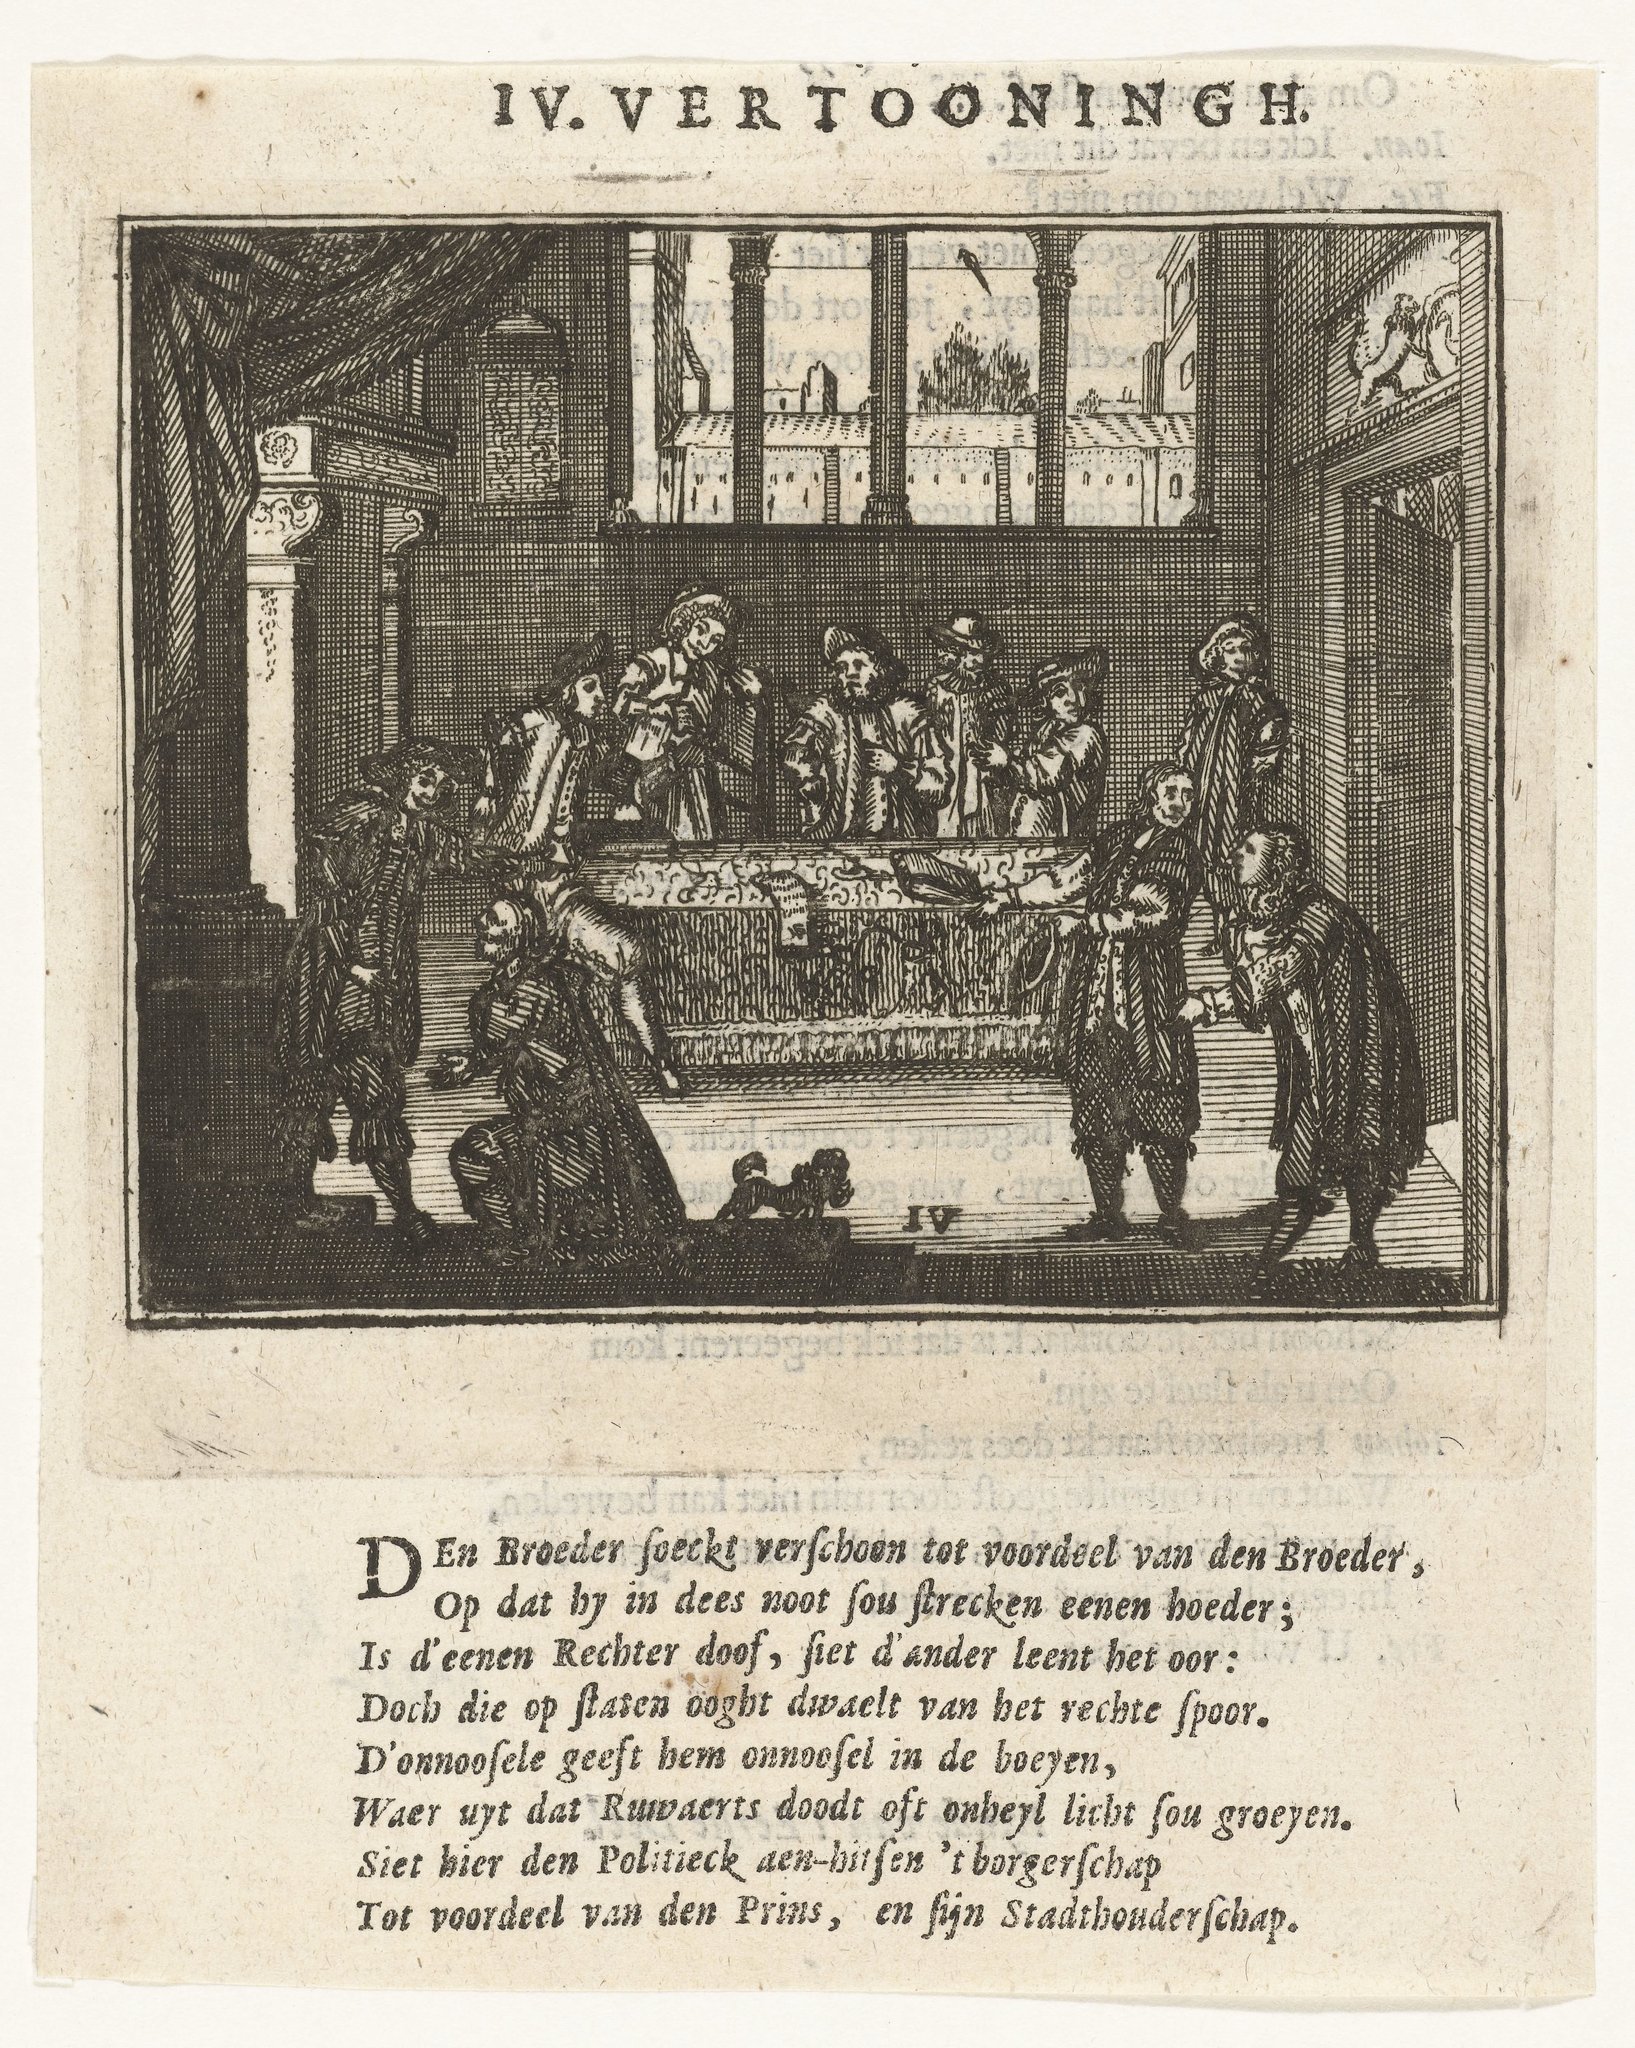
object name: print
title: Johan de Witt pleit voor zijn broer, 1672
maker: Anonymous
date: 1672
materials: paper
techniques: etching, letterpress printing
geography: southern netherlands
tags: dordrecht, the hague, cornelis de witt, johan de witt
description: Johan de Witt pleit voor de vrijlating van zijn broer, 1672. Scène uit het leven van Johan en Cornelis de Witt; onderdeel van een groep illustraties, genummerd: IV. Vertooningh en vergezeld van een vers van 8 regels. Bedrukt op achterzijde met tekst in het Nederlands.